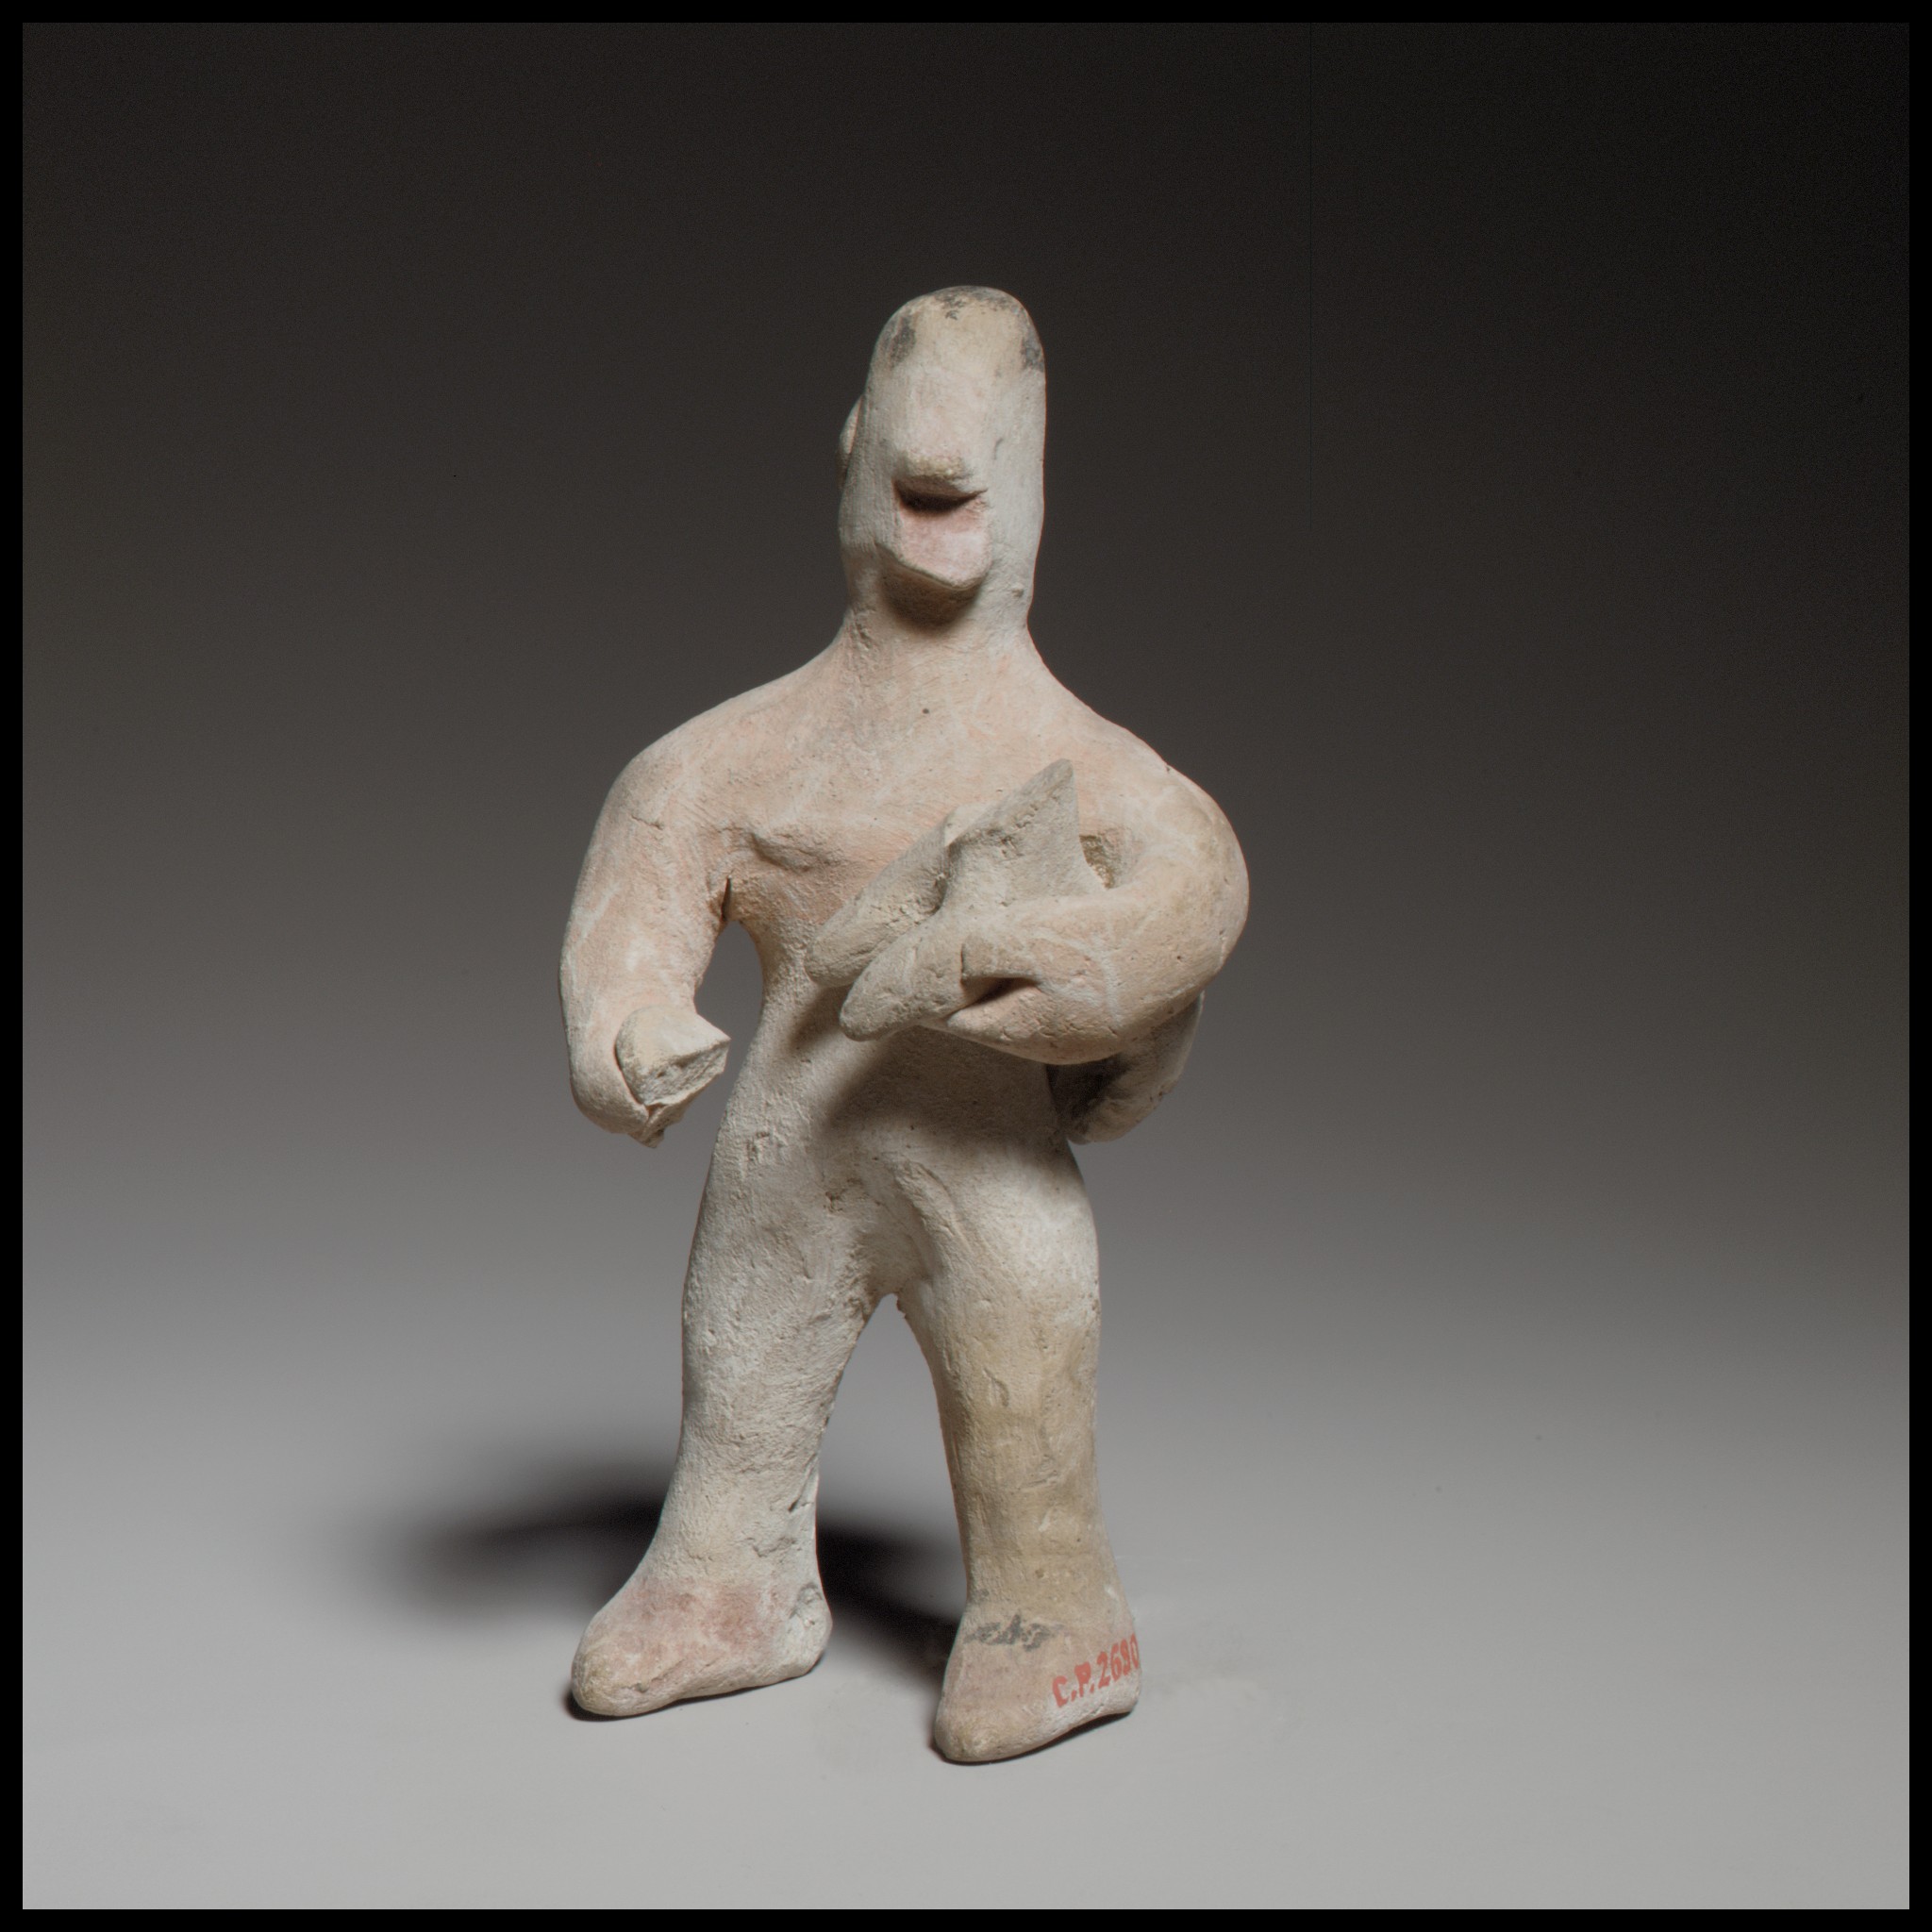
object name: statuette of a votary, male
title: Standing male figurine holding a quadruped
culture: cypriot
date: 600-480 BCE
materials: terracotta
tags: animals,men